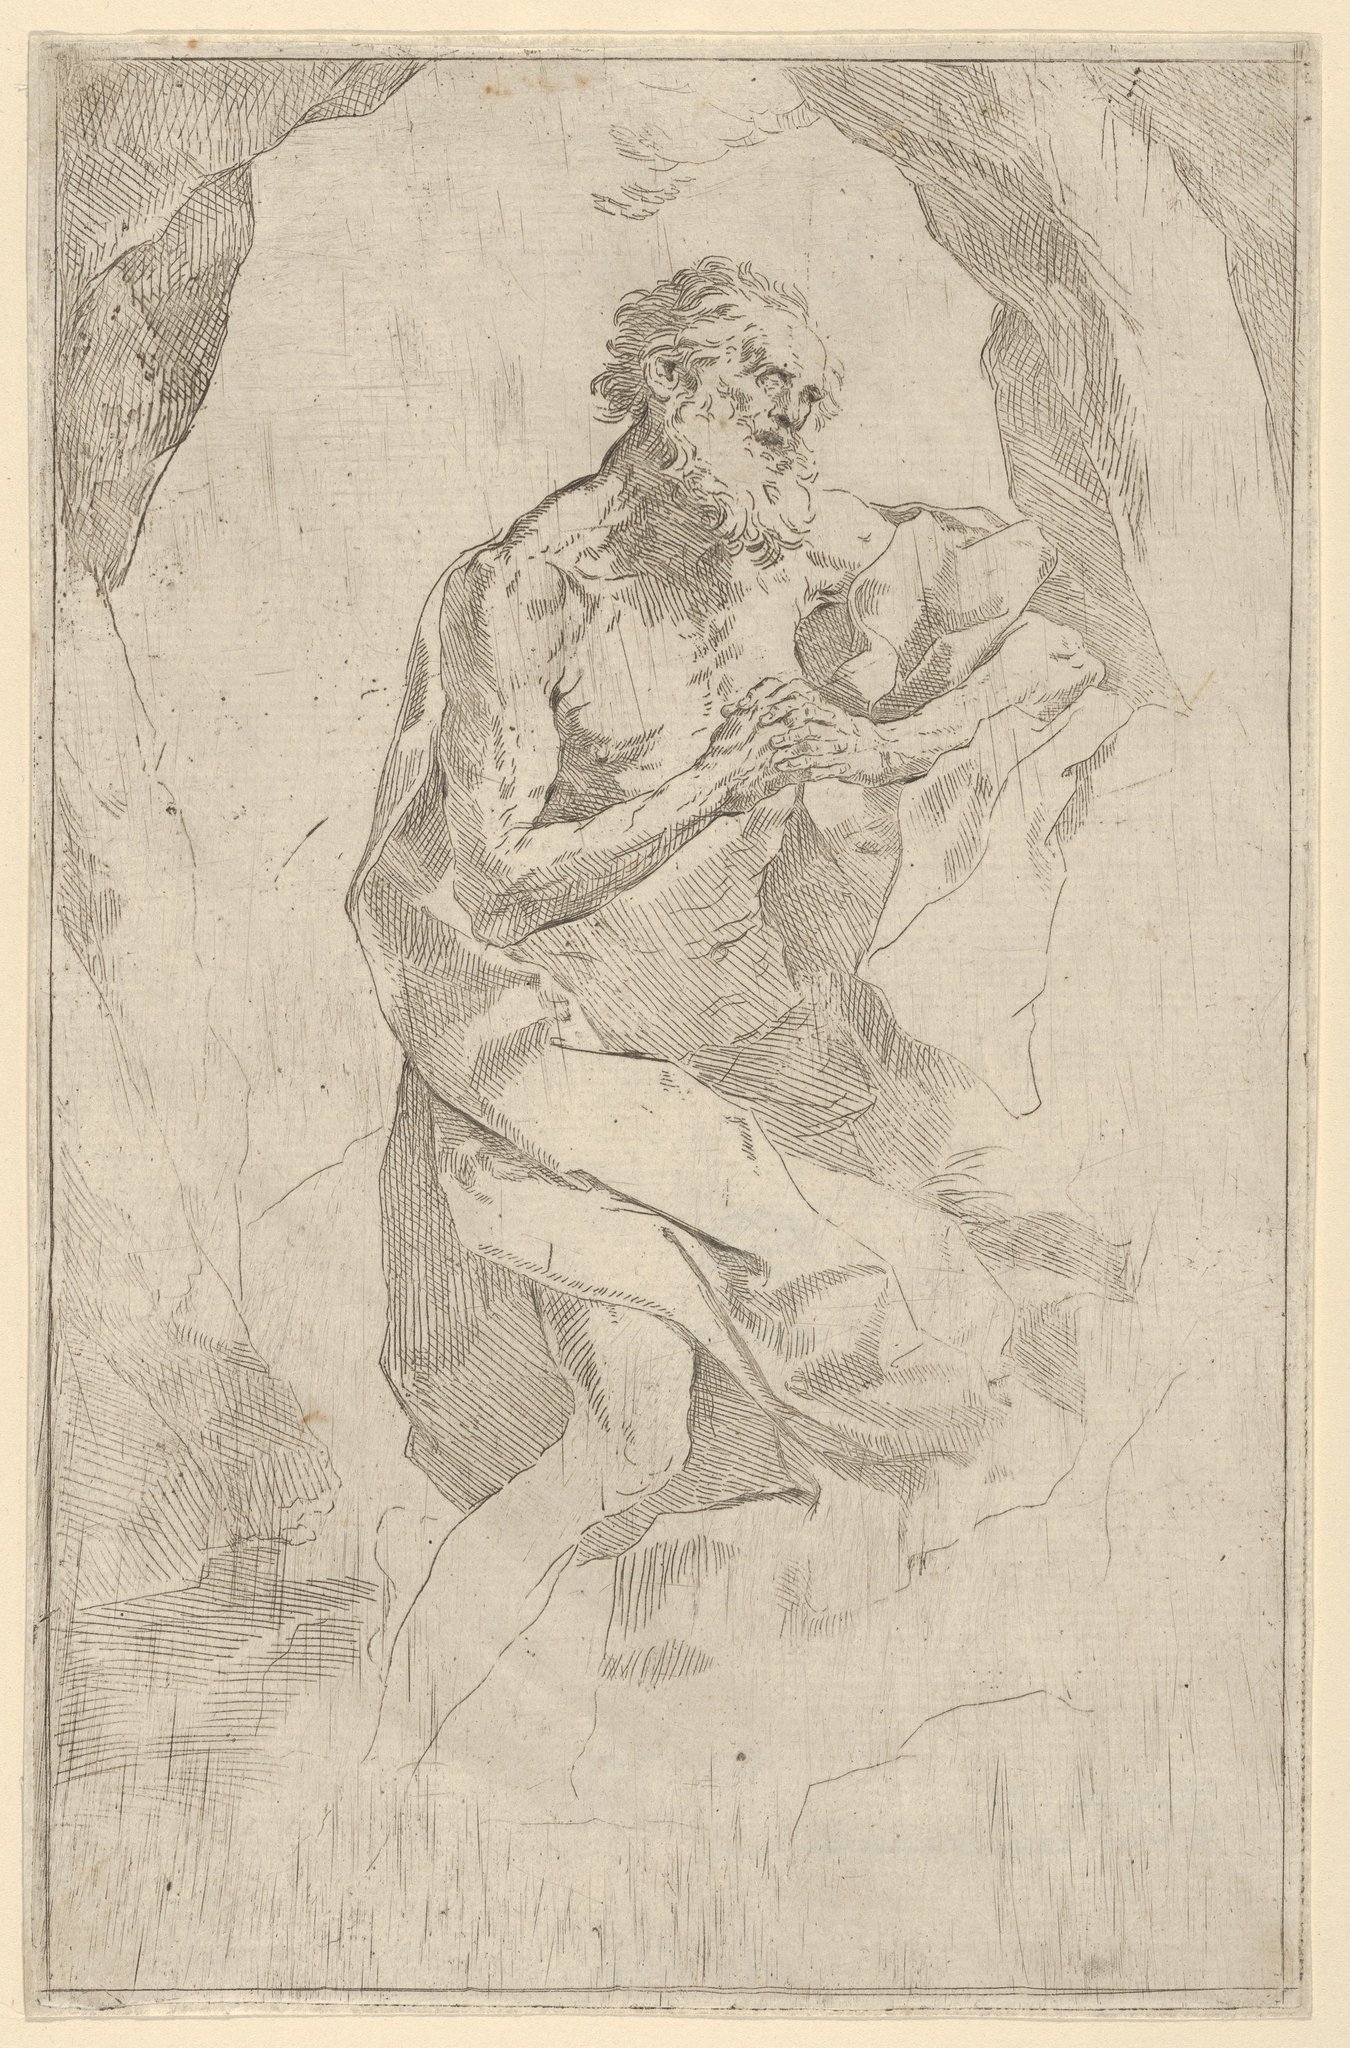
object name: print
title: Saint Jerome kneeling on a rock facing right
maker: anonymous, 17th century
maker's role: artist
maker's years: 1600-1700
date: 1600-1640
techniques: etching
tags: saint jerome